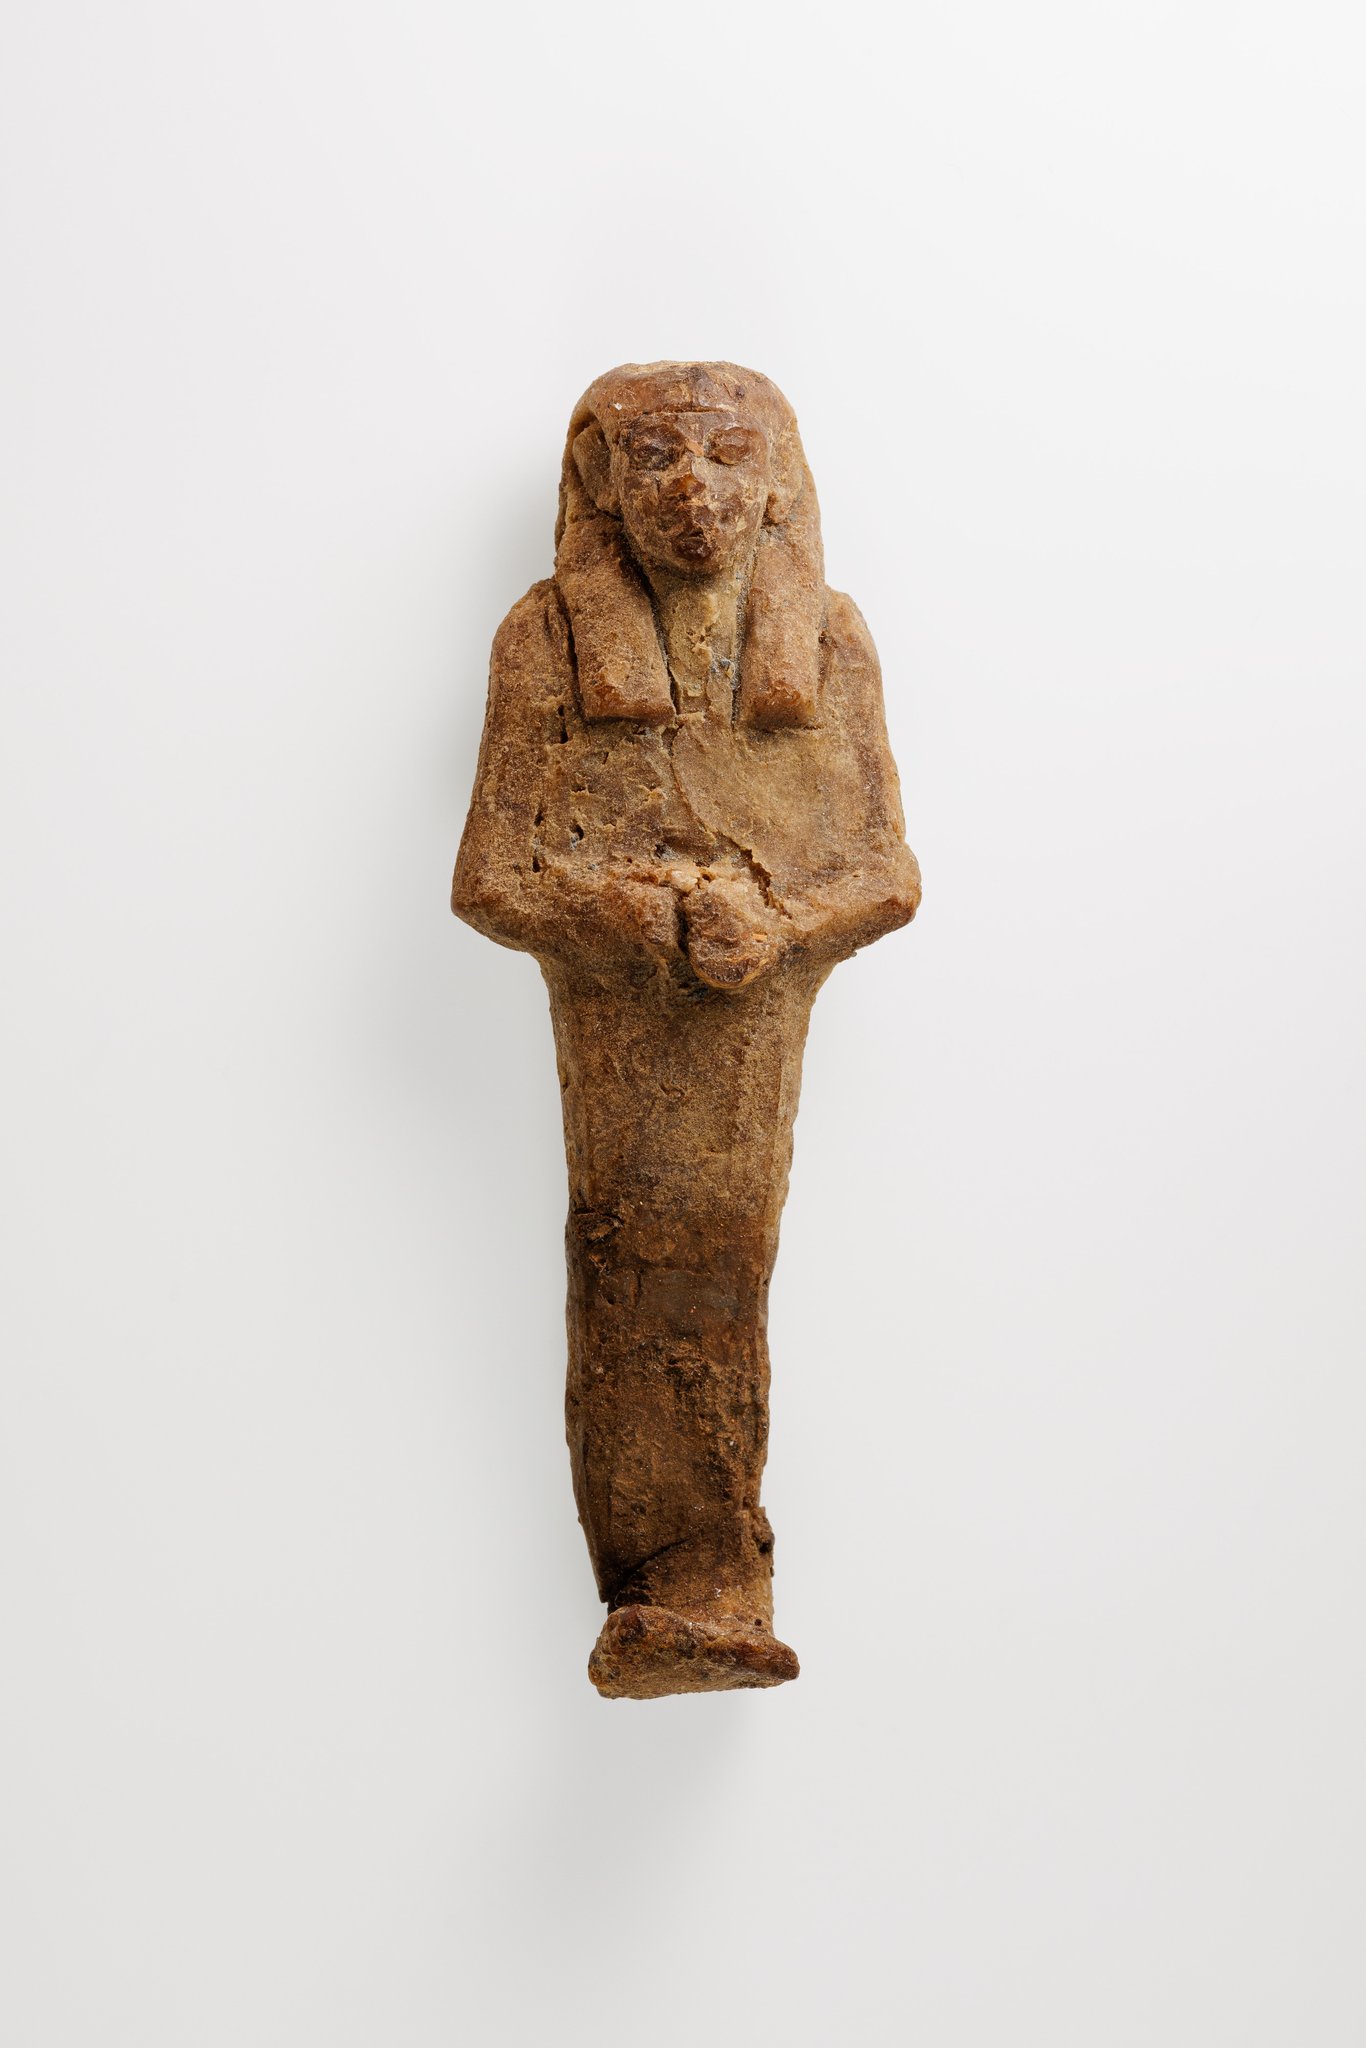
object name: four son of horus, imseti, human headed, nesenaset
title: Viscera figure with human head (Imseti)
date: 1000-945 BCE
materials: mud, wax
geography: egypt